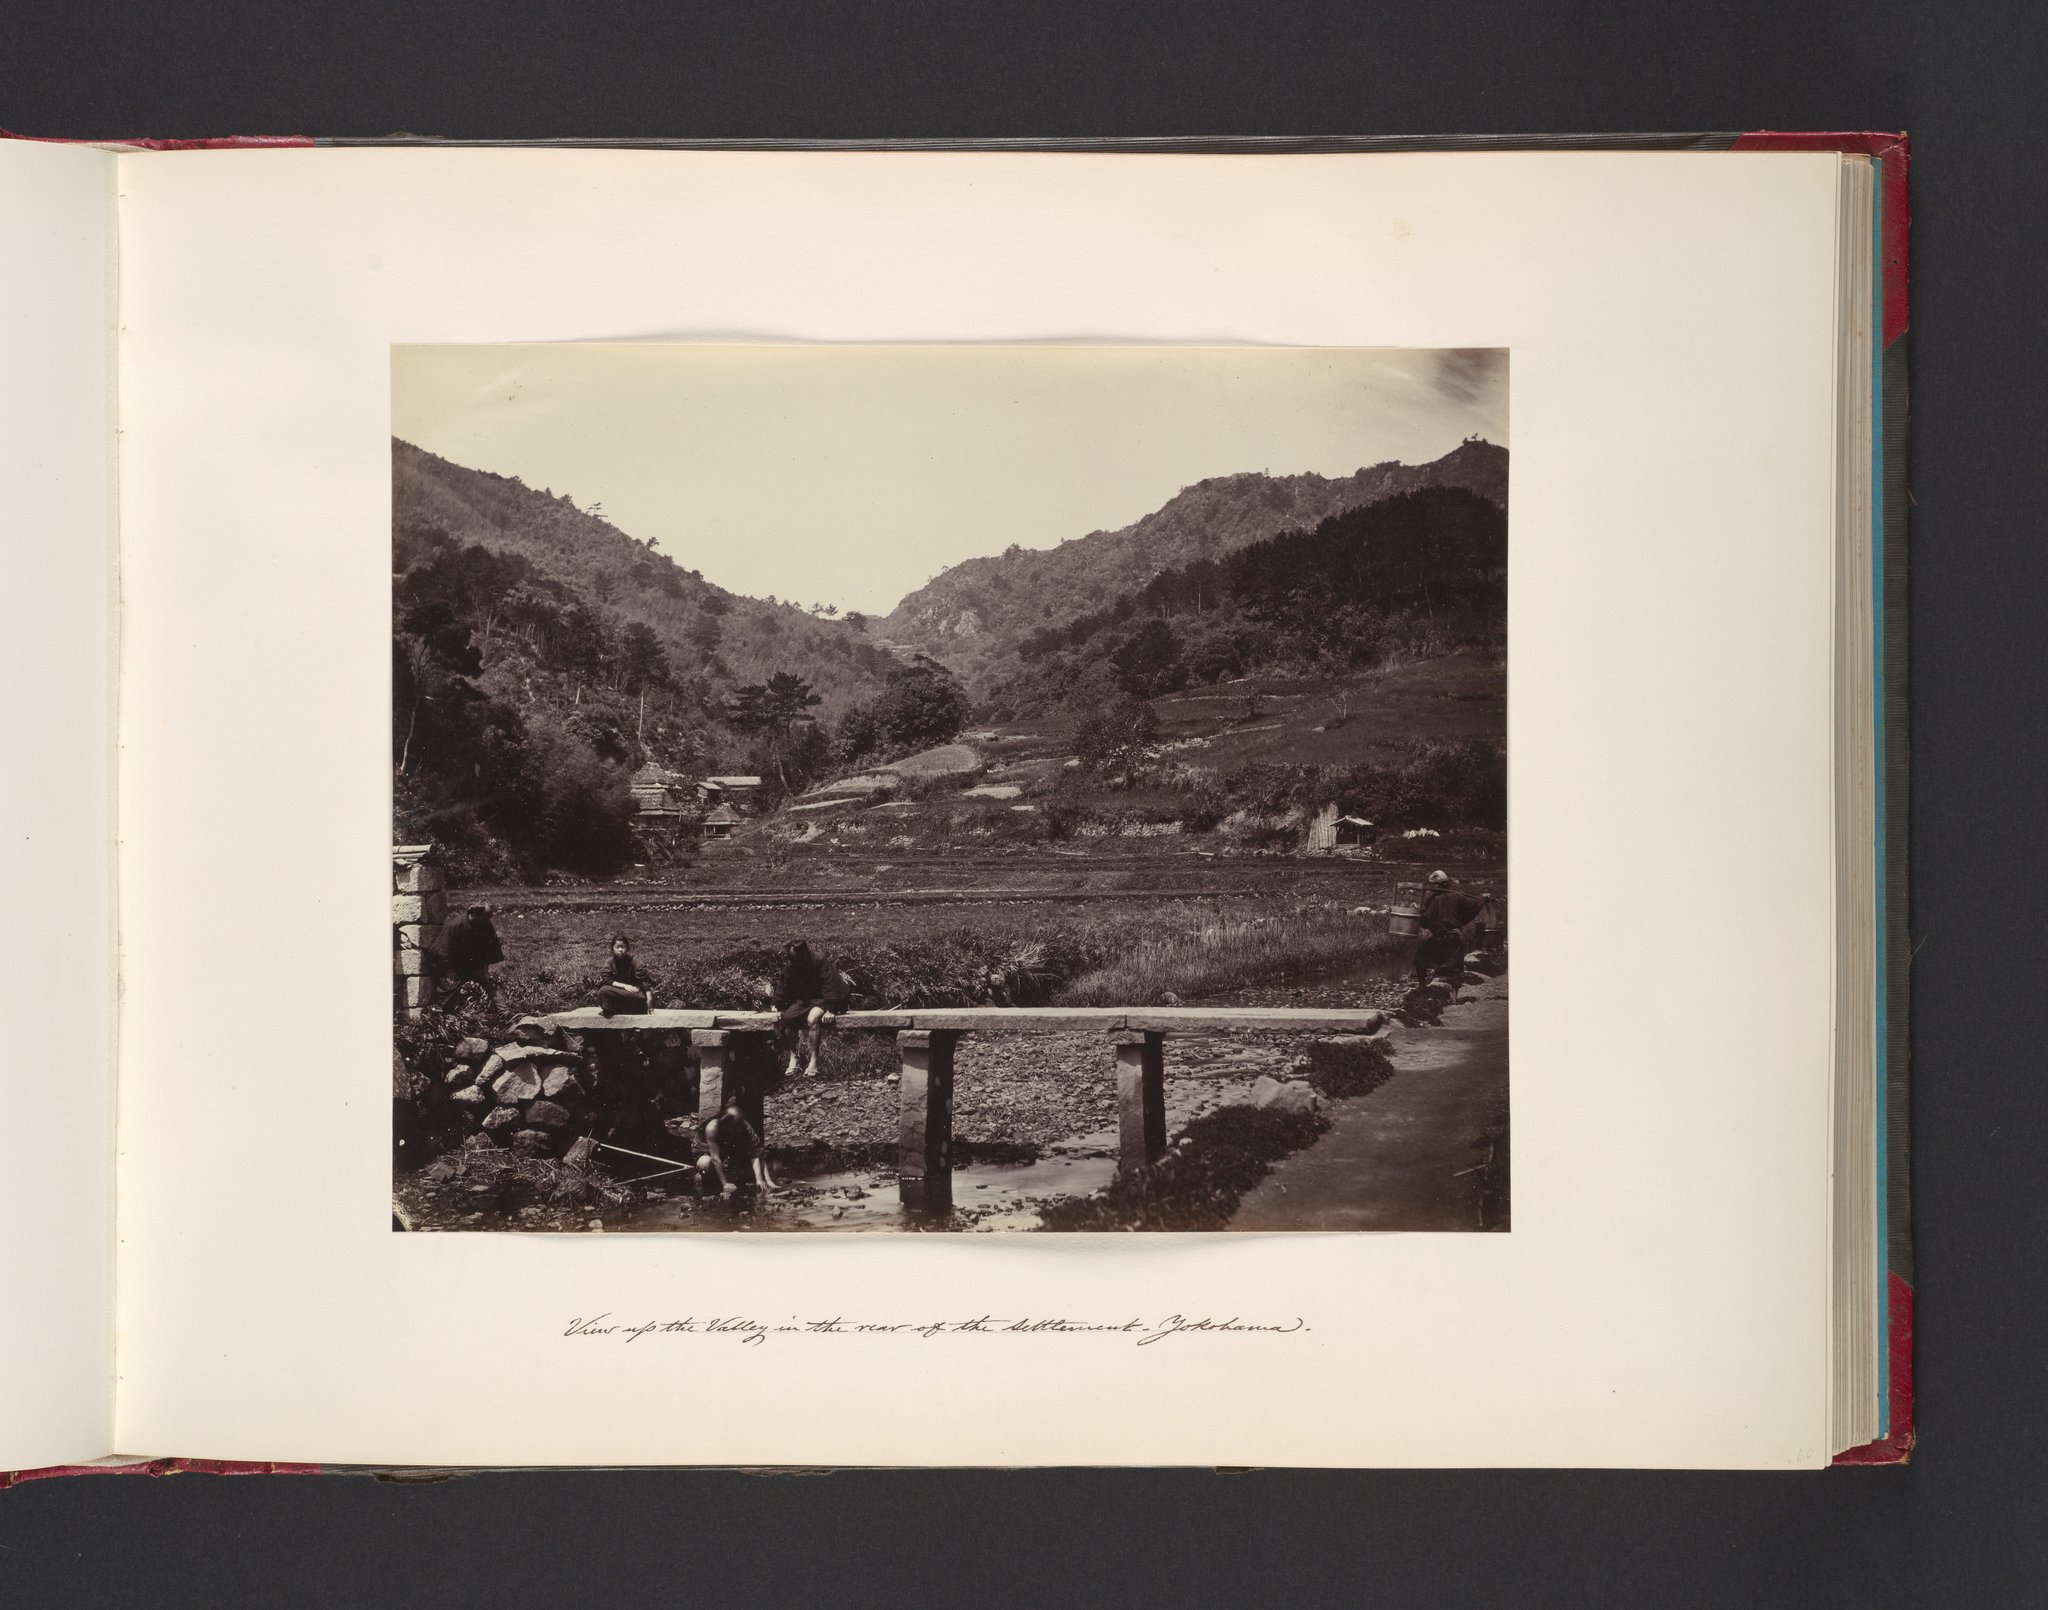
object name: photograph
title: View up the Valley in the Rear of the Settlement, Yokohama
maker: john thomson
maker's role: artist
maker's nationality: british, scottish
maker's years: 1837-1921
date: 1865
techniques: albumen silver print, glass negative